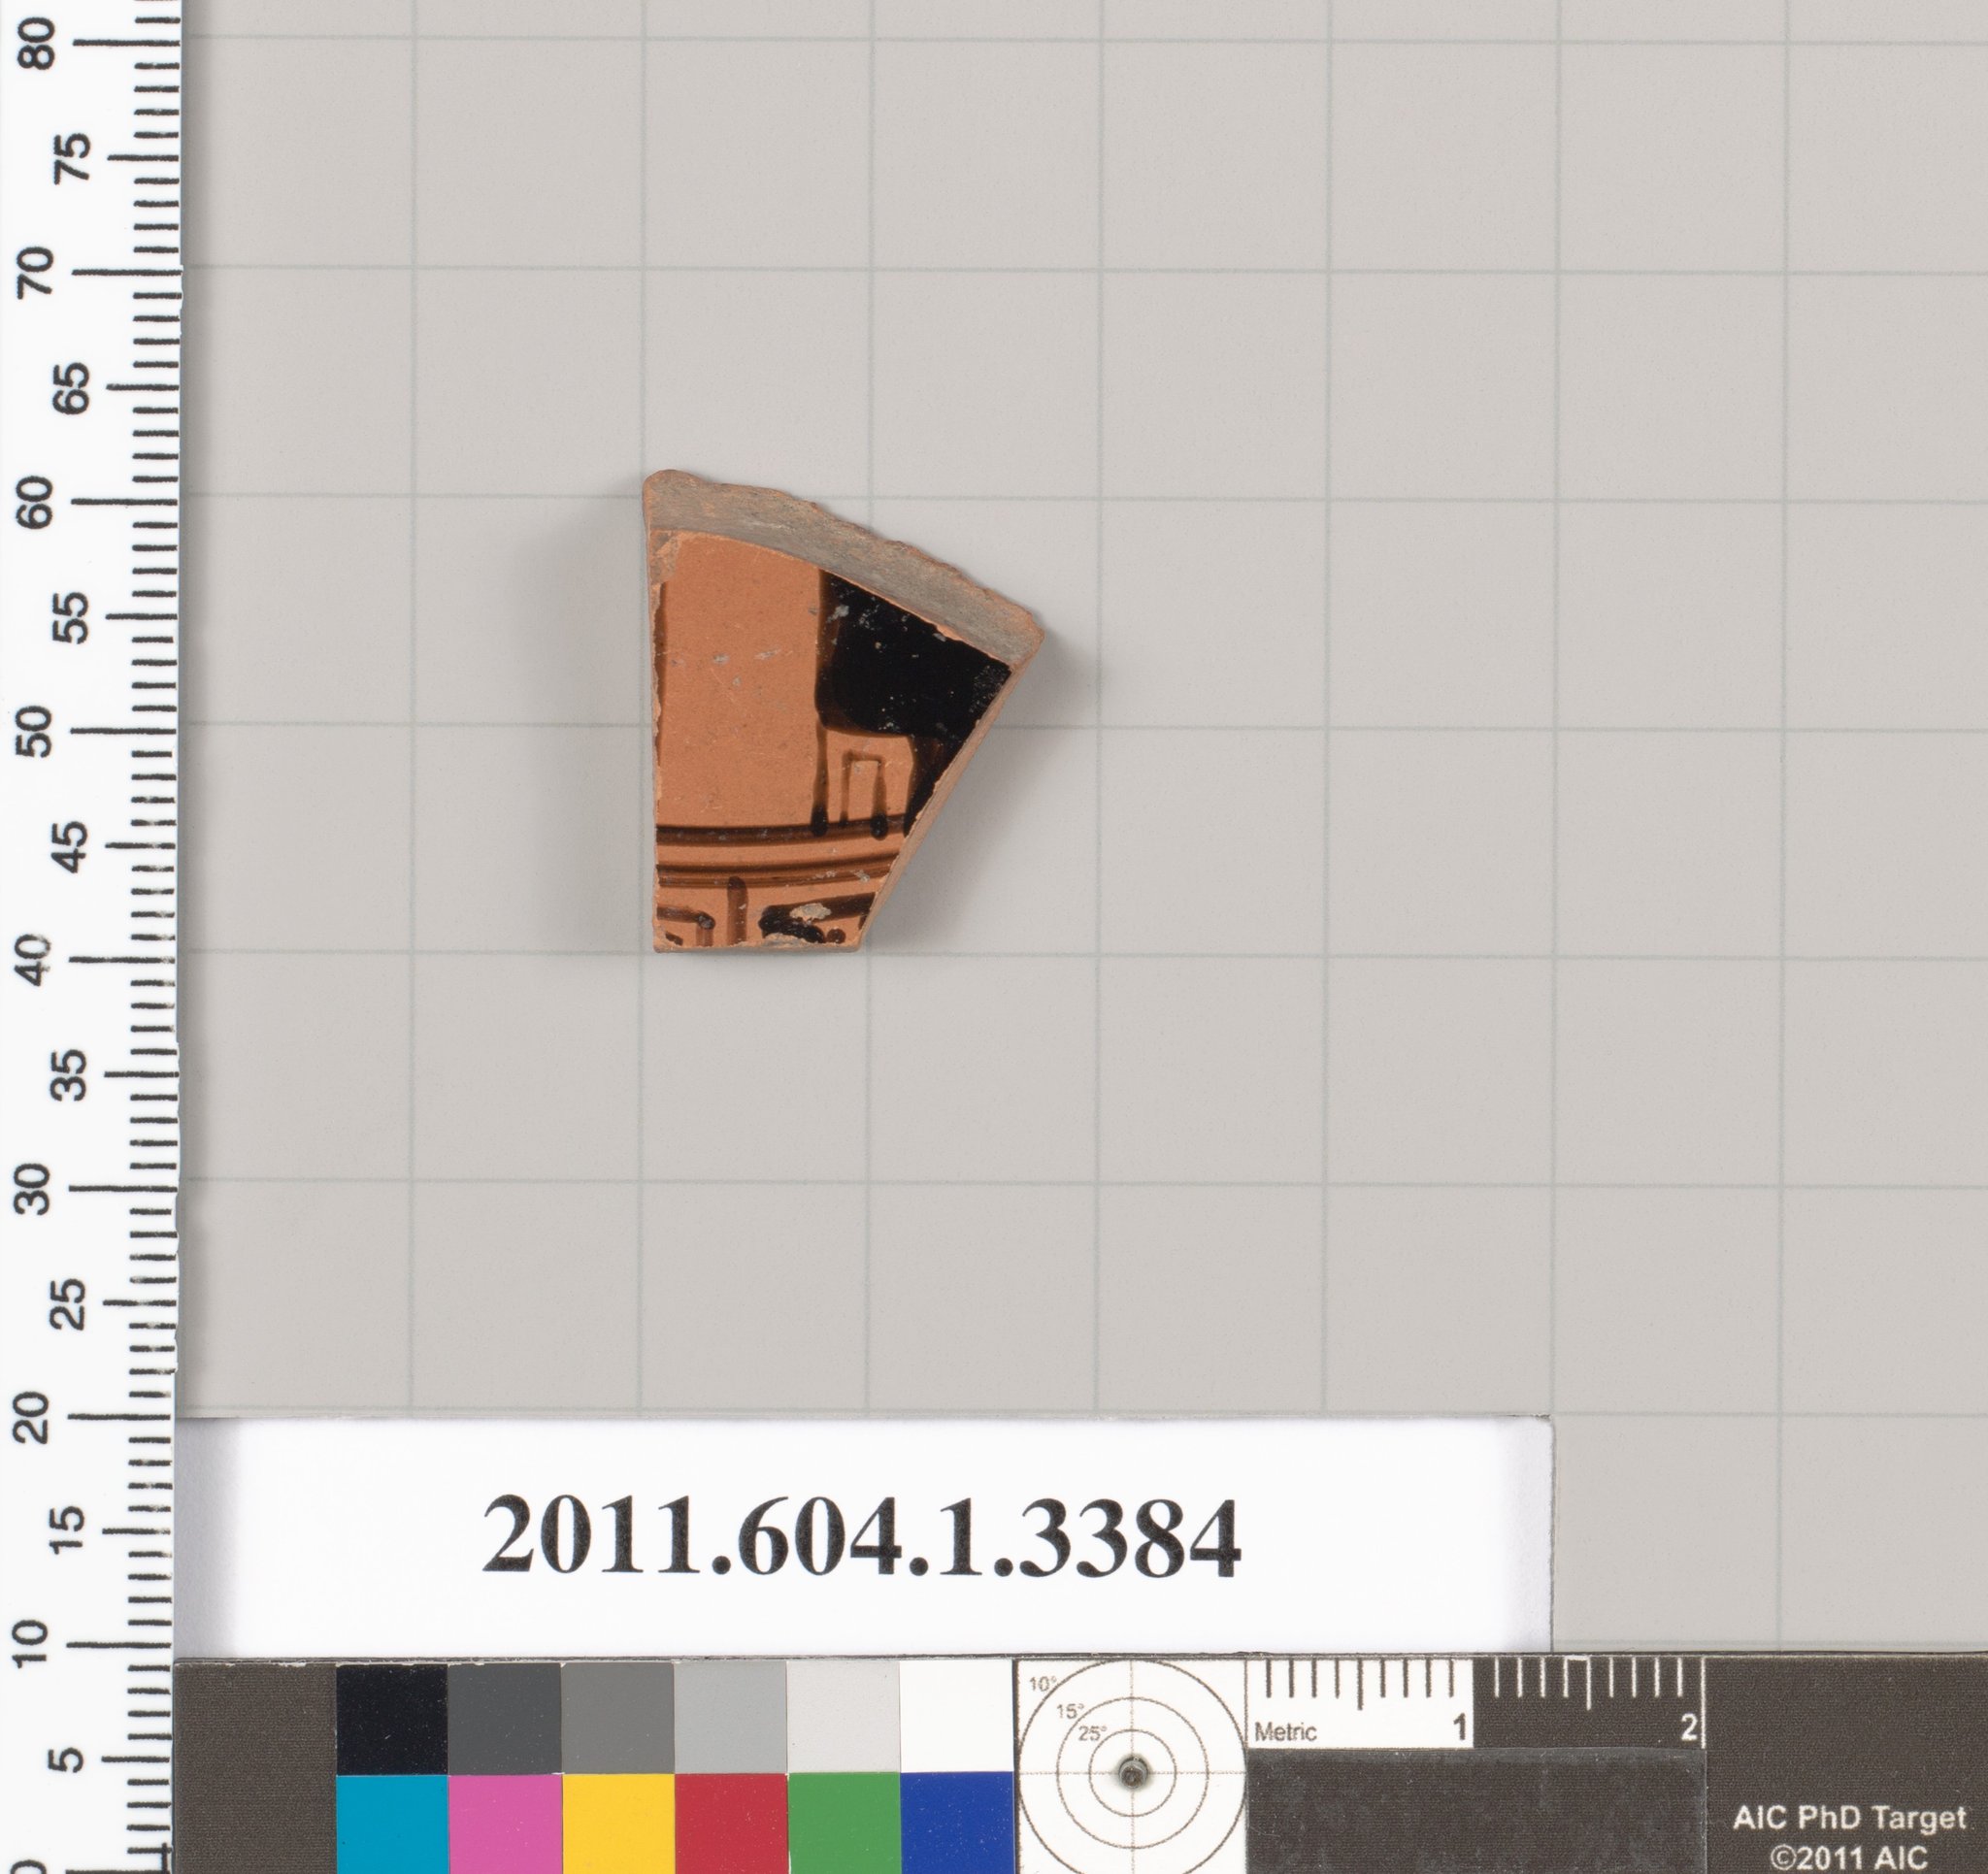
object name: kylix fragment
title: Terracotta fragment of a kylix (drinking cup)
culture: greek, attic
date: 475-451 BCE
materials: terracotta